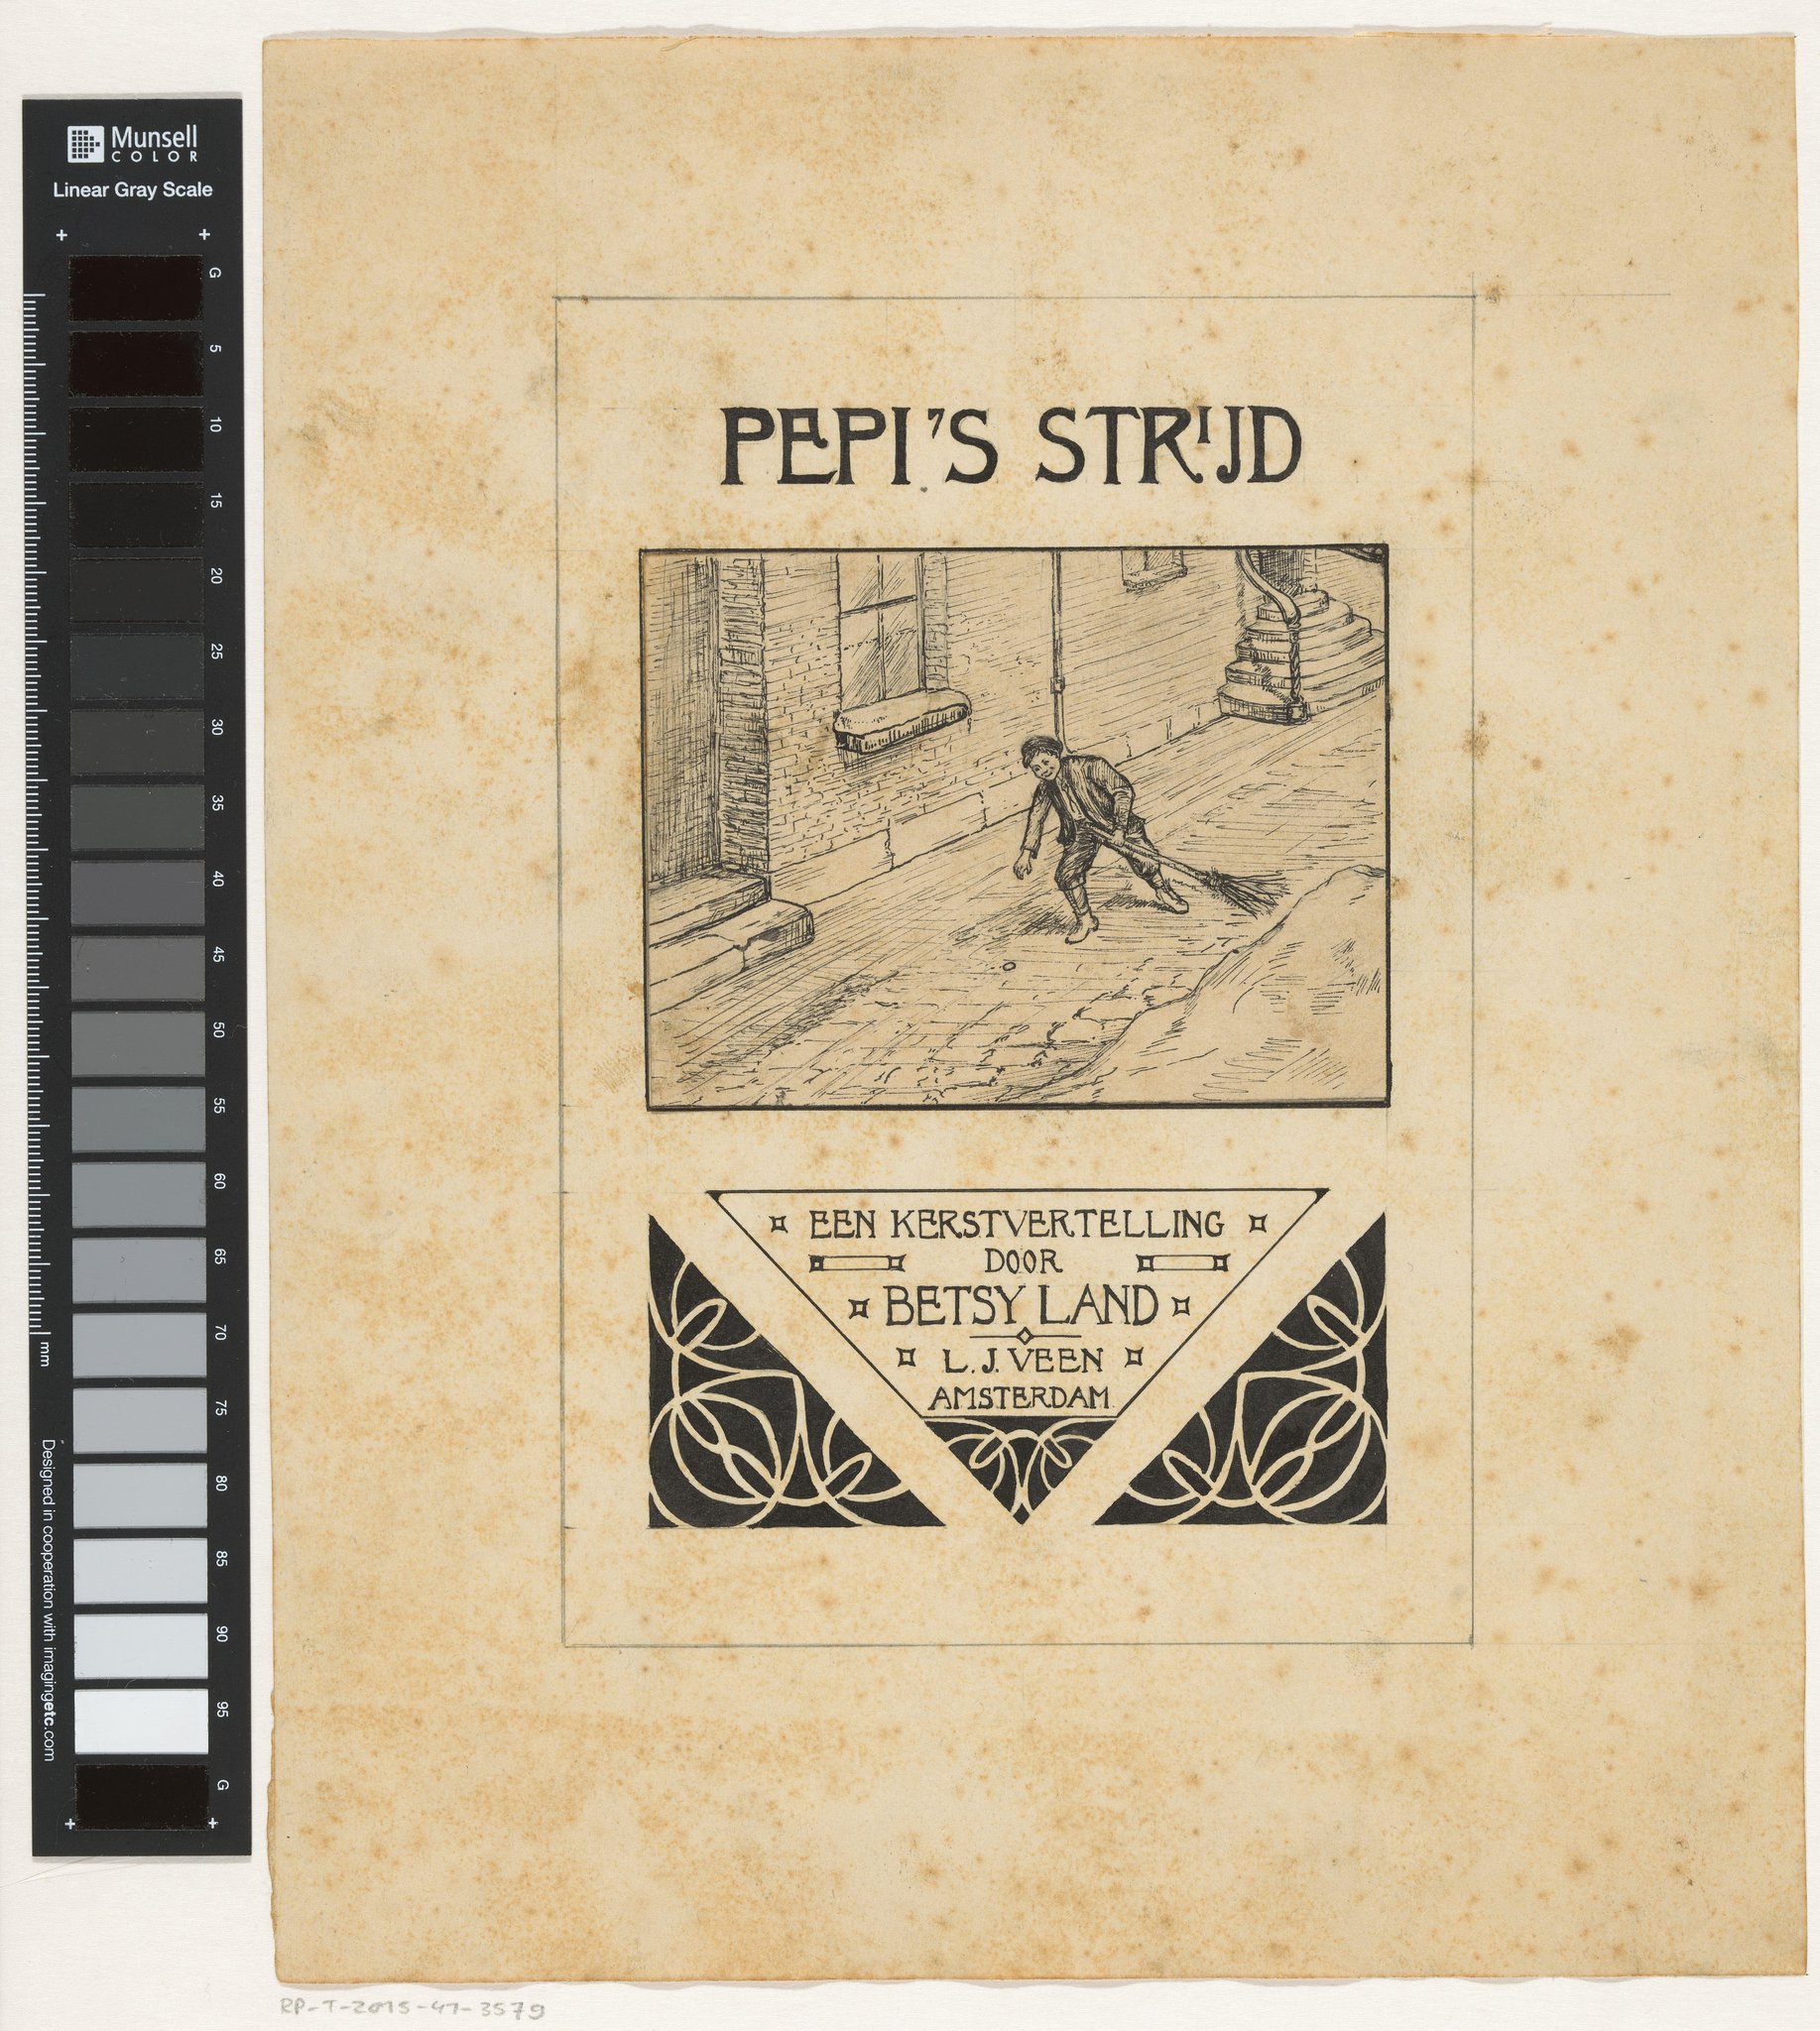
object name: drawing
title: Bandontwerp voor: Betsy Land, Pepi's strijd. Een kerstvertelling, 1907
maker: Anonymous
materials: ink, paper, pencil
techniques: brush, pen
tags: boy (child between toddler and youth), (household) utensils and implements (with name), street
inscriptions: :, number: ‘2’, collector's mark: Lugt 2228a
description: Een jongen met een bezem in de hand loopt voorovergebogen over een straat. Onderaan in een driehoek de auteursnaam en uitgever geflankeerd door twee driehoeken met florale lijnmotieven.